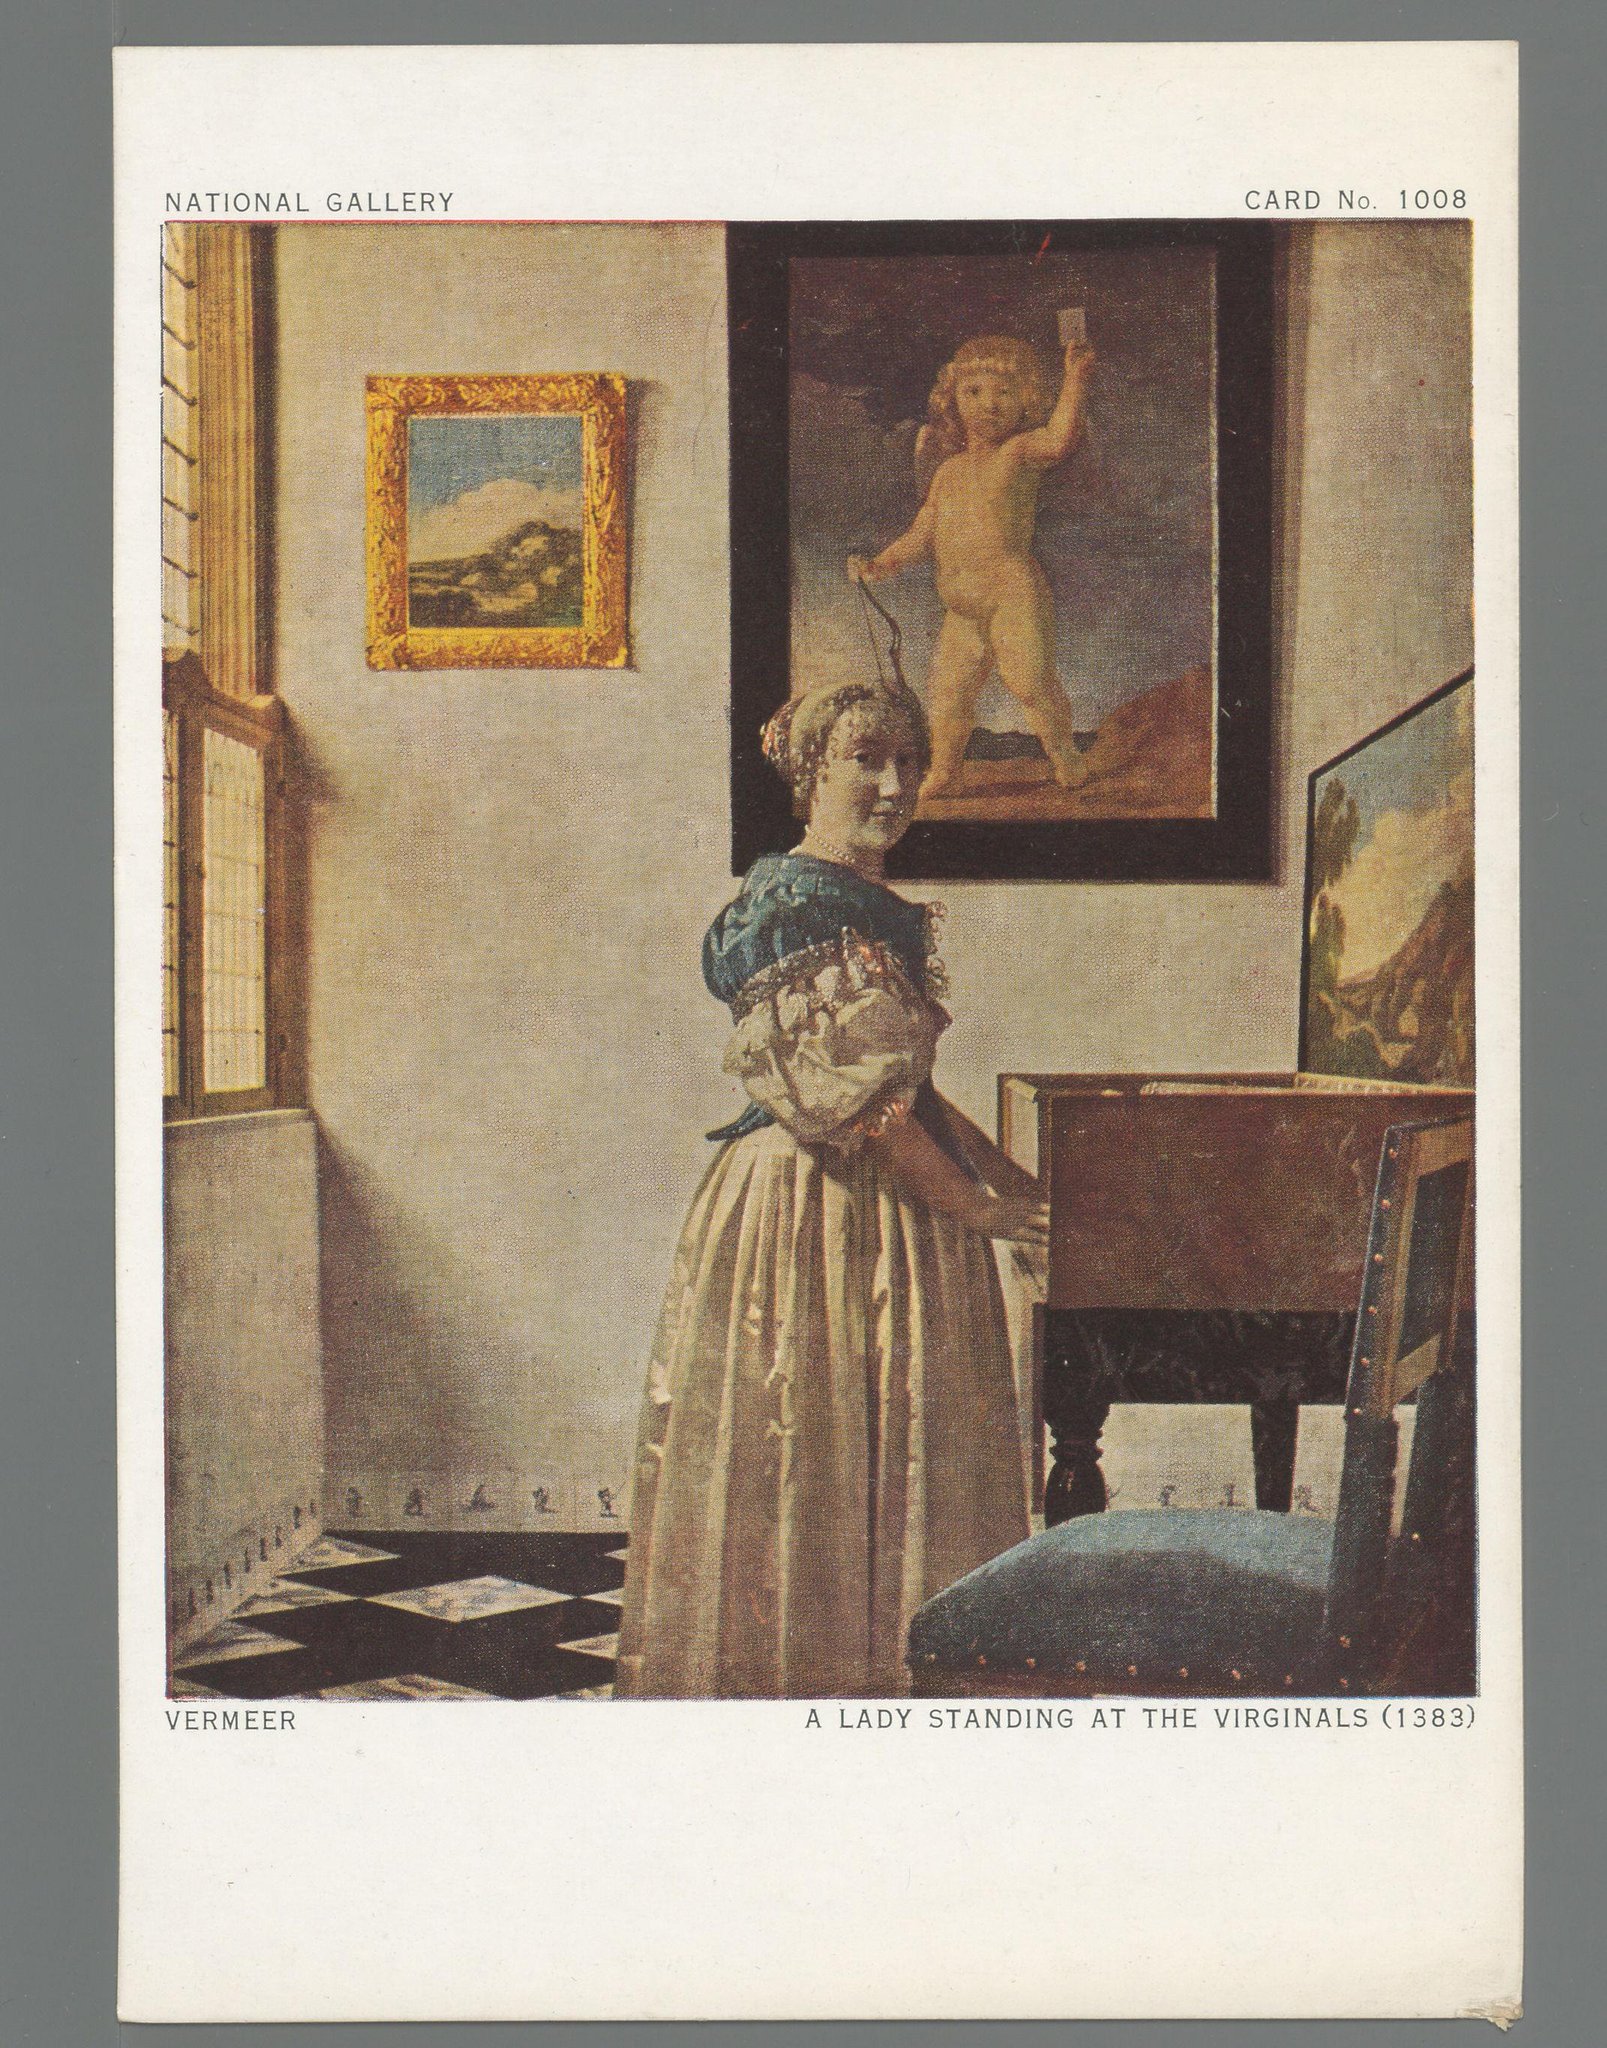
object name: reproduction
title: National Gallery. Vermeer. A lady standing at the virginals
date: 1902-1950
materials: cardboard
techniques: color autotype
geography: london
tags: permanent exhibition, museum, picture, painting